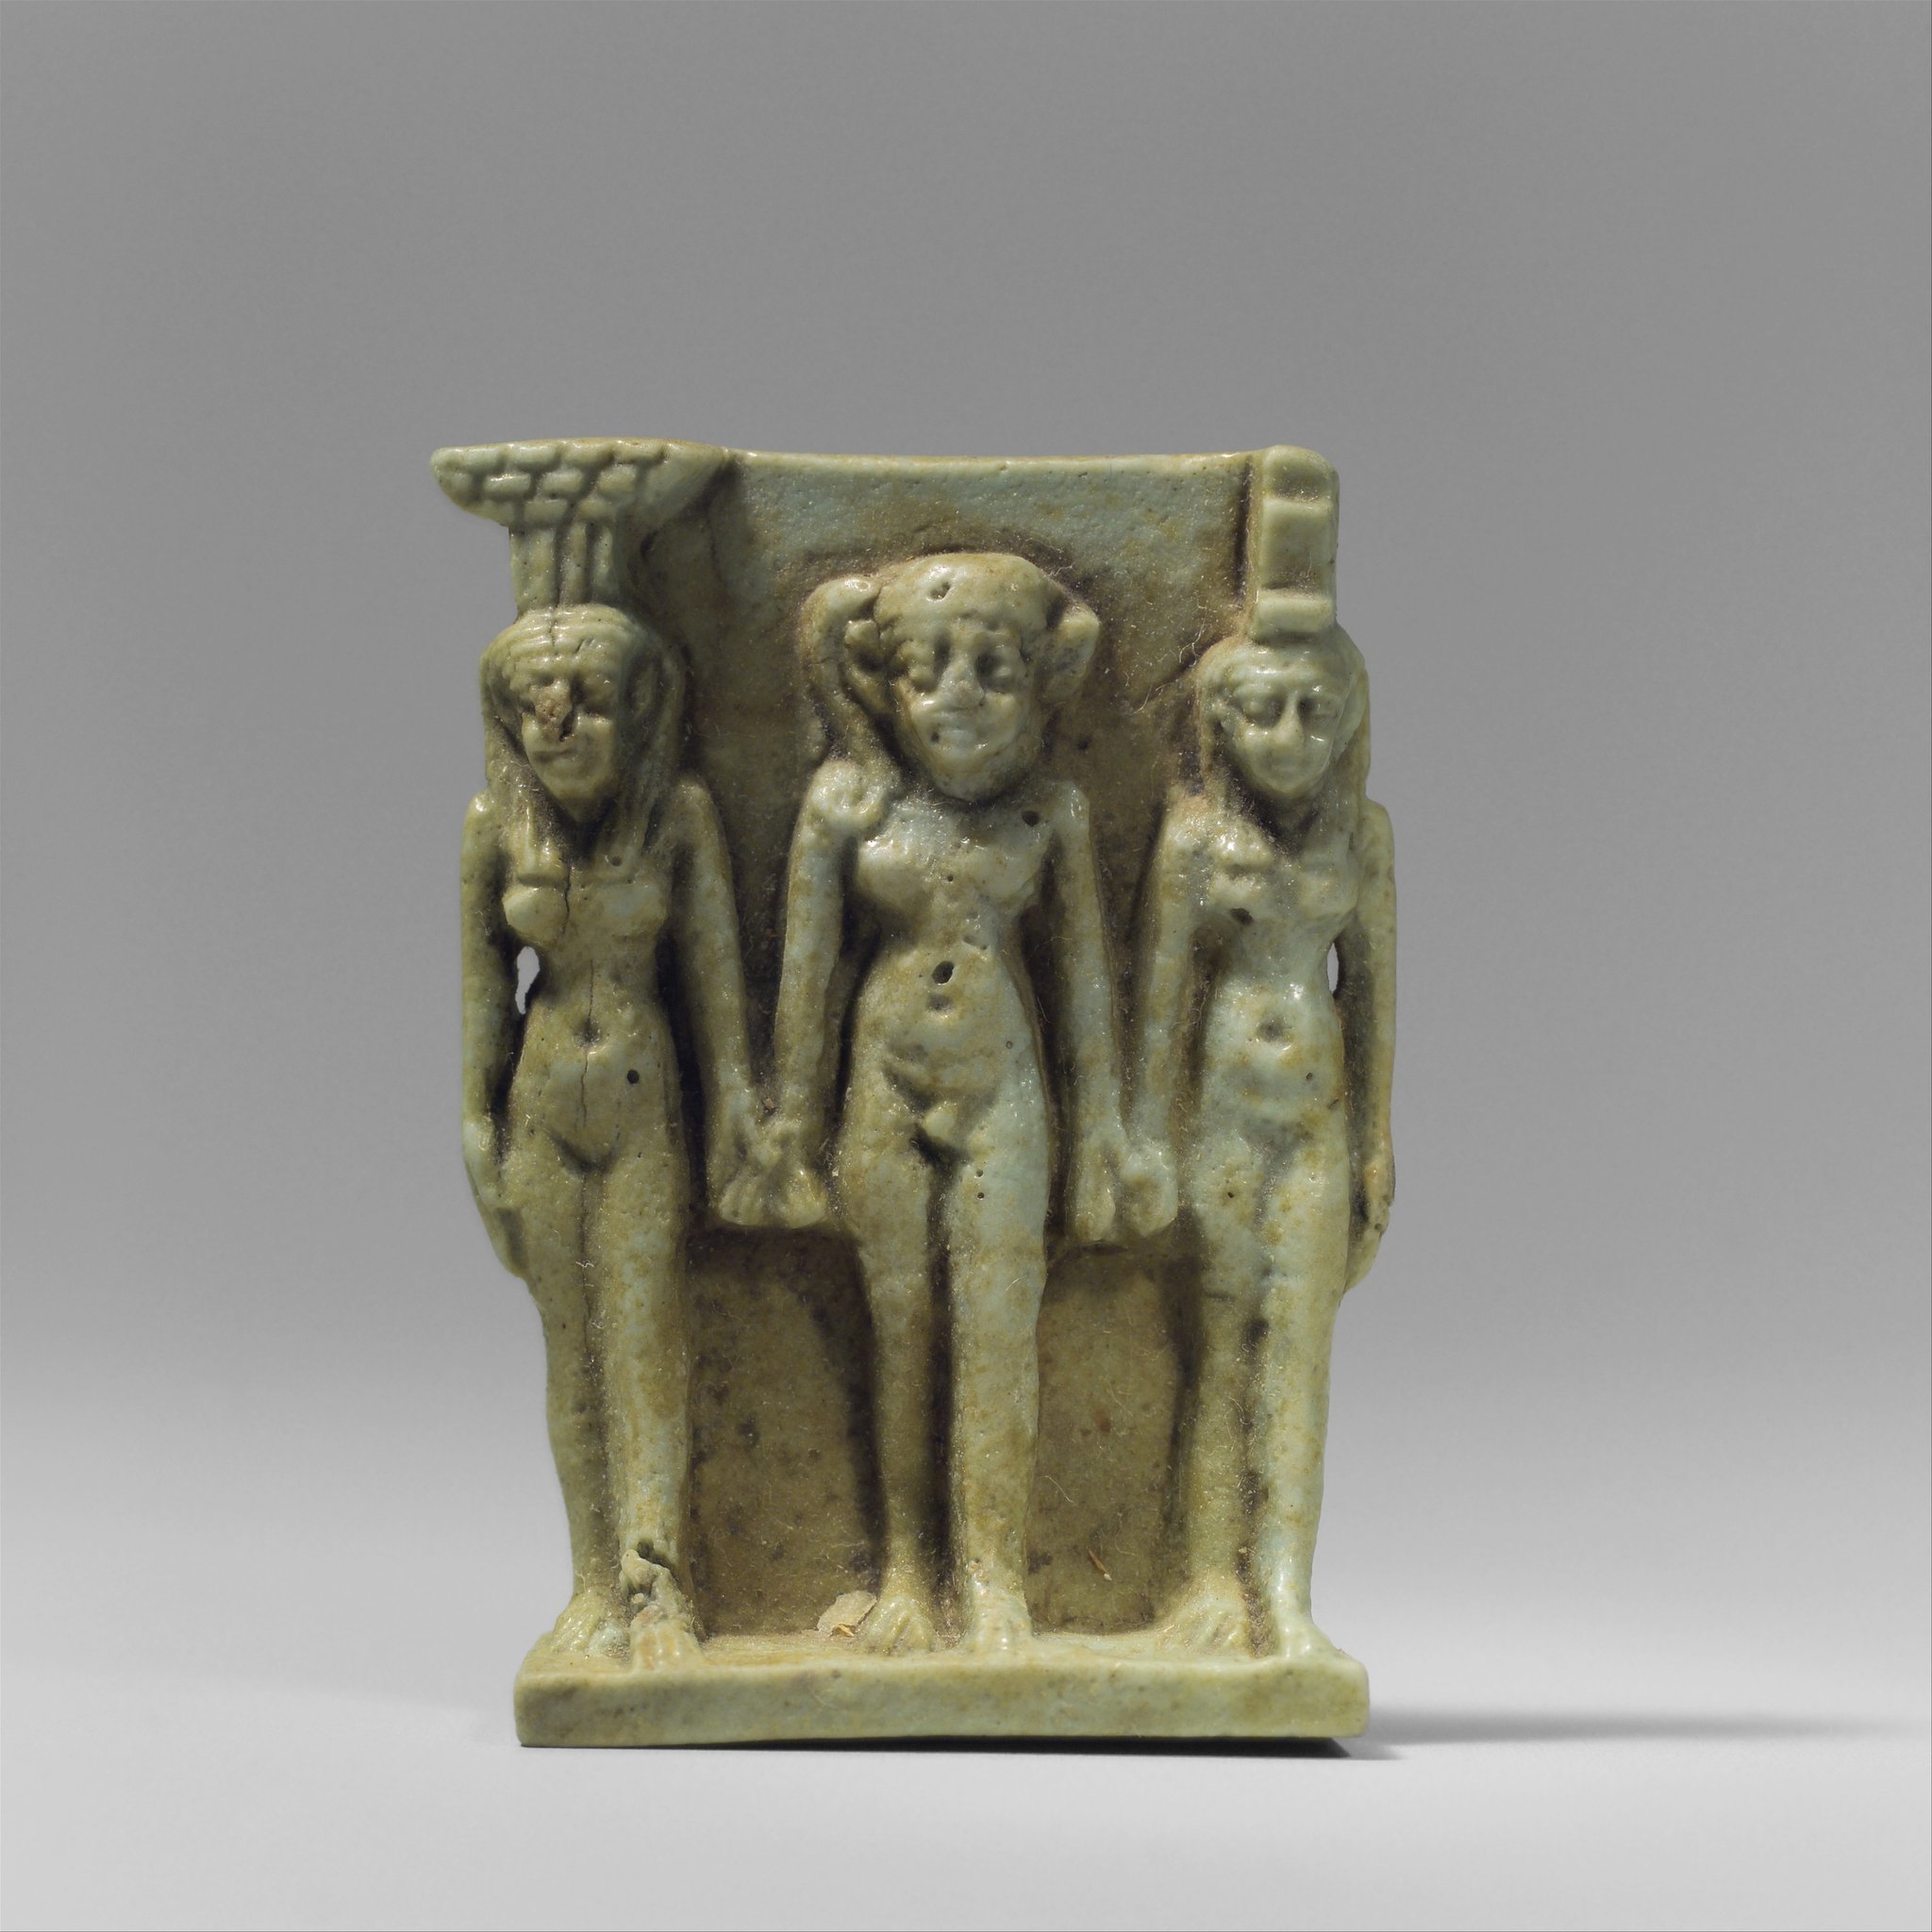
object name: amulet group, nephthys, horus, isi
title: Nephthys, Horus, and Isis Amulet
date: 664-525 BCE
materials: faience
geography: egypt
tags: horus,isis